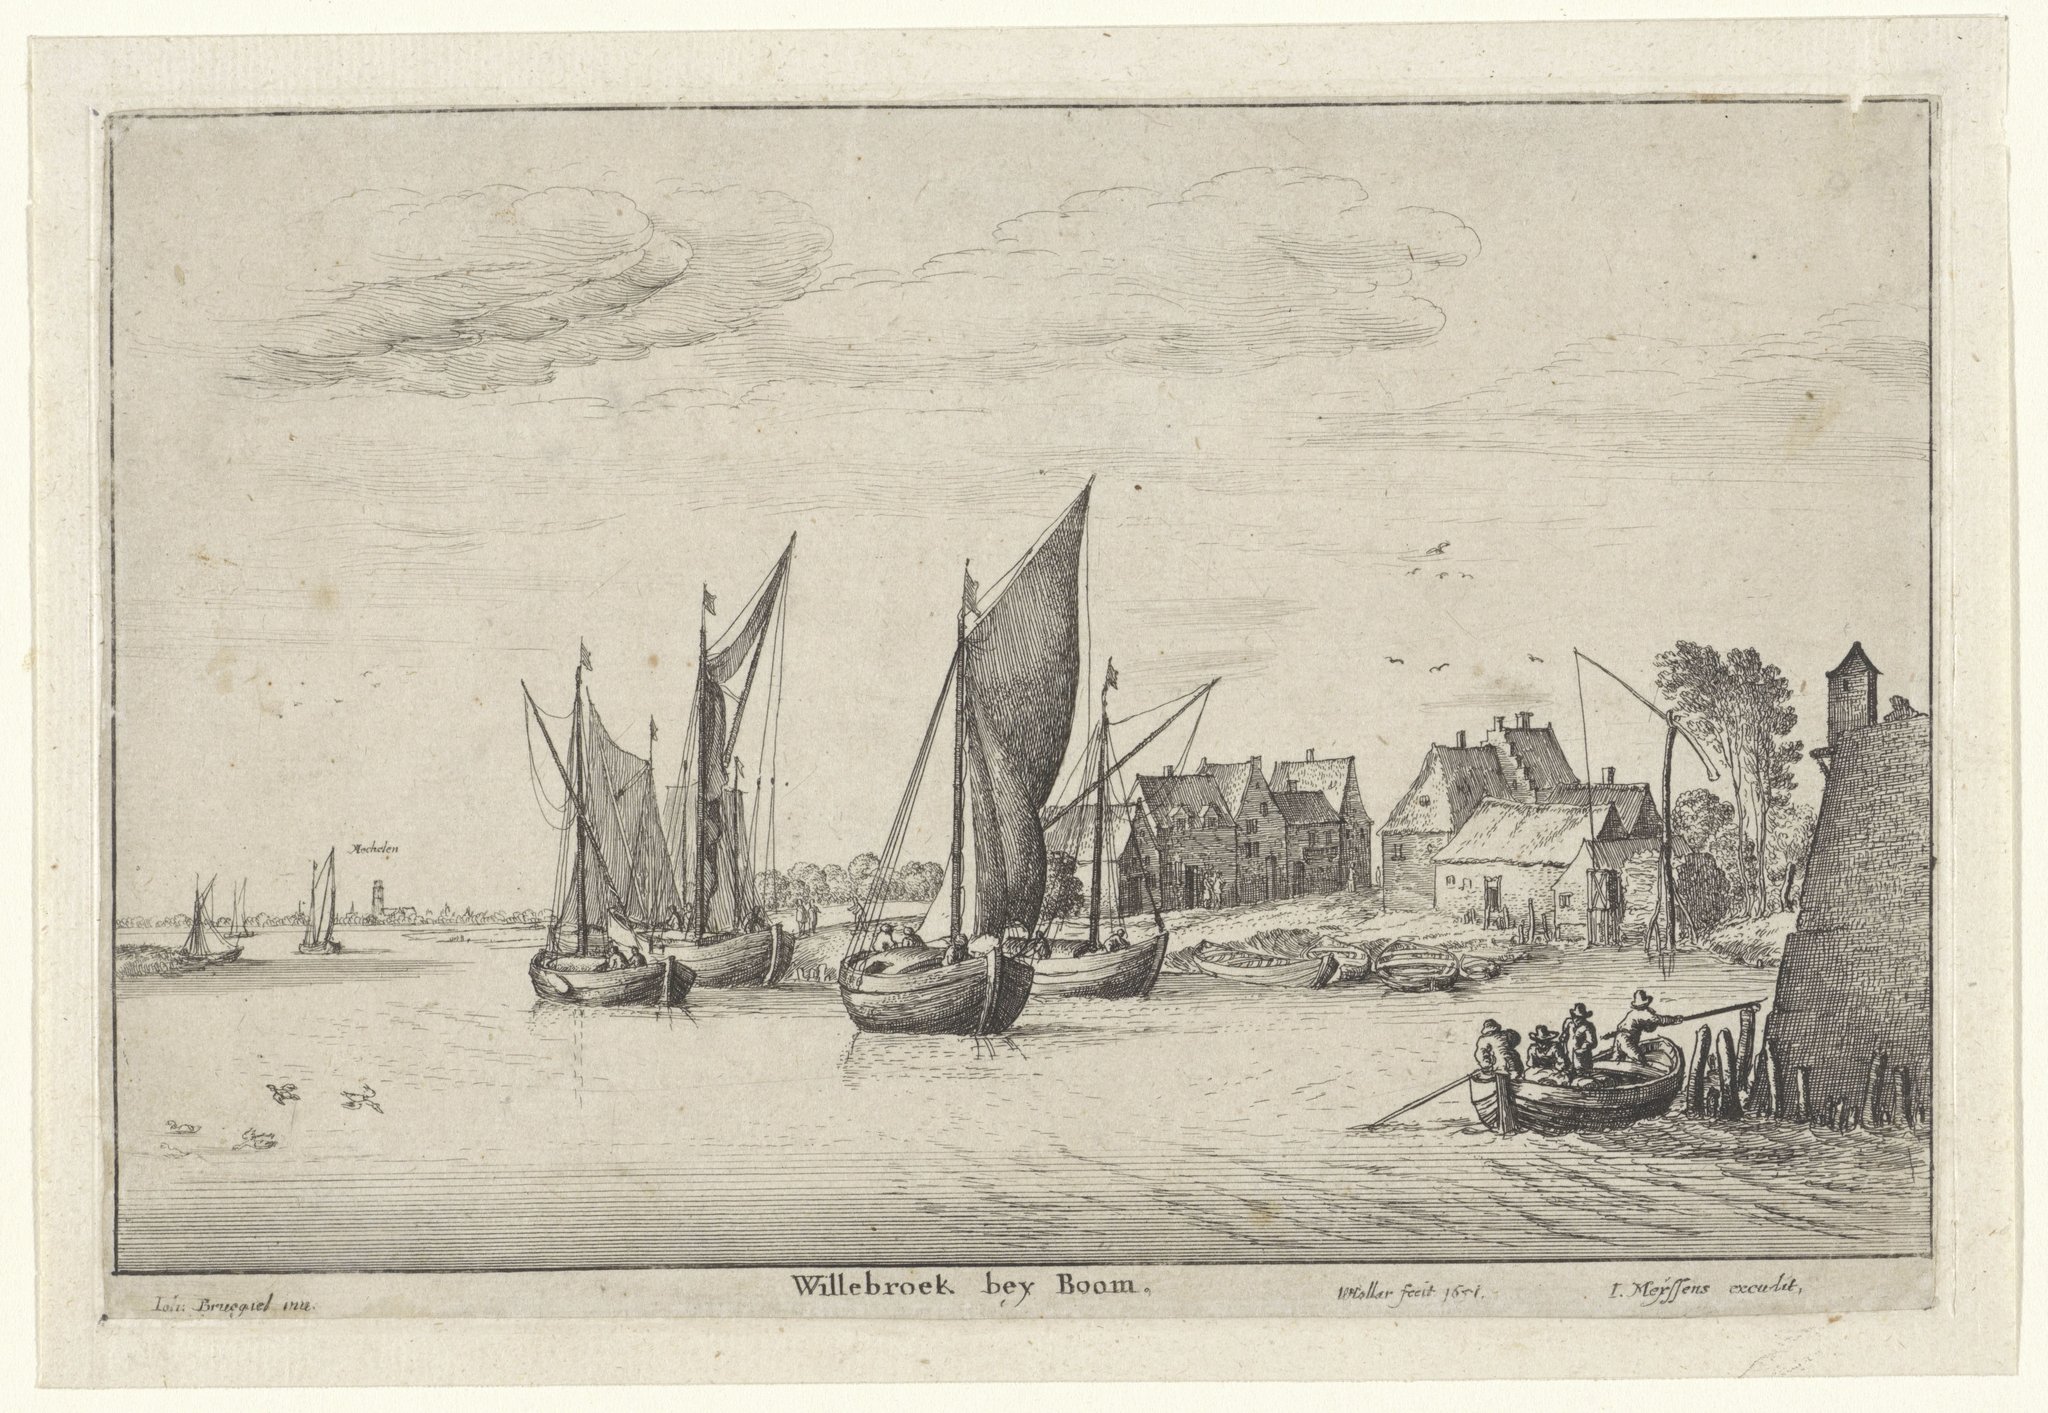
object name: print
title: Riviergezichten en kustgezichten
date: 1651-1670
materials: paper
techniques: etching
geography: antwerp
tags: city-view, and landscape with man-made constructions, sailing-ship, sailing-boat, river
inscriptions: collector's mark: Lugt 240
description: De prent maakt deel uit van een zesdelige serie riviergezichten en kustgezichten, ongenummerd.